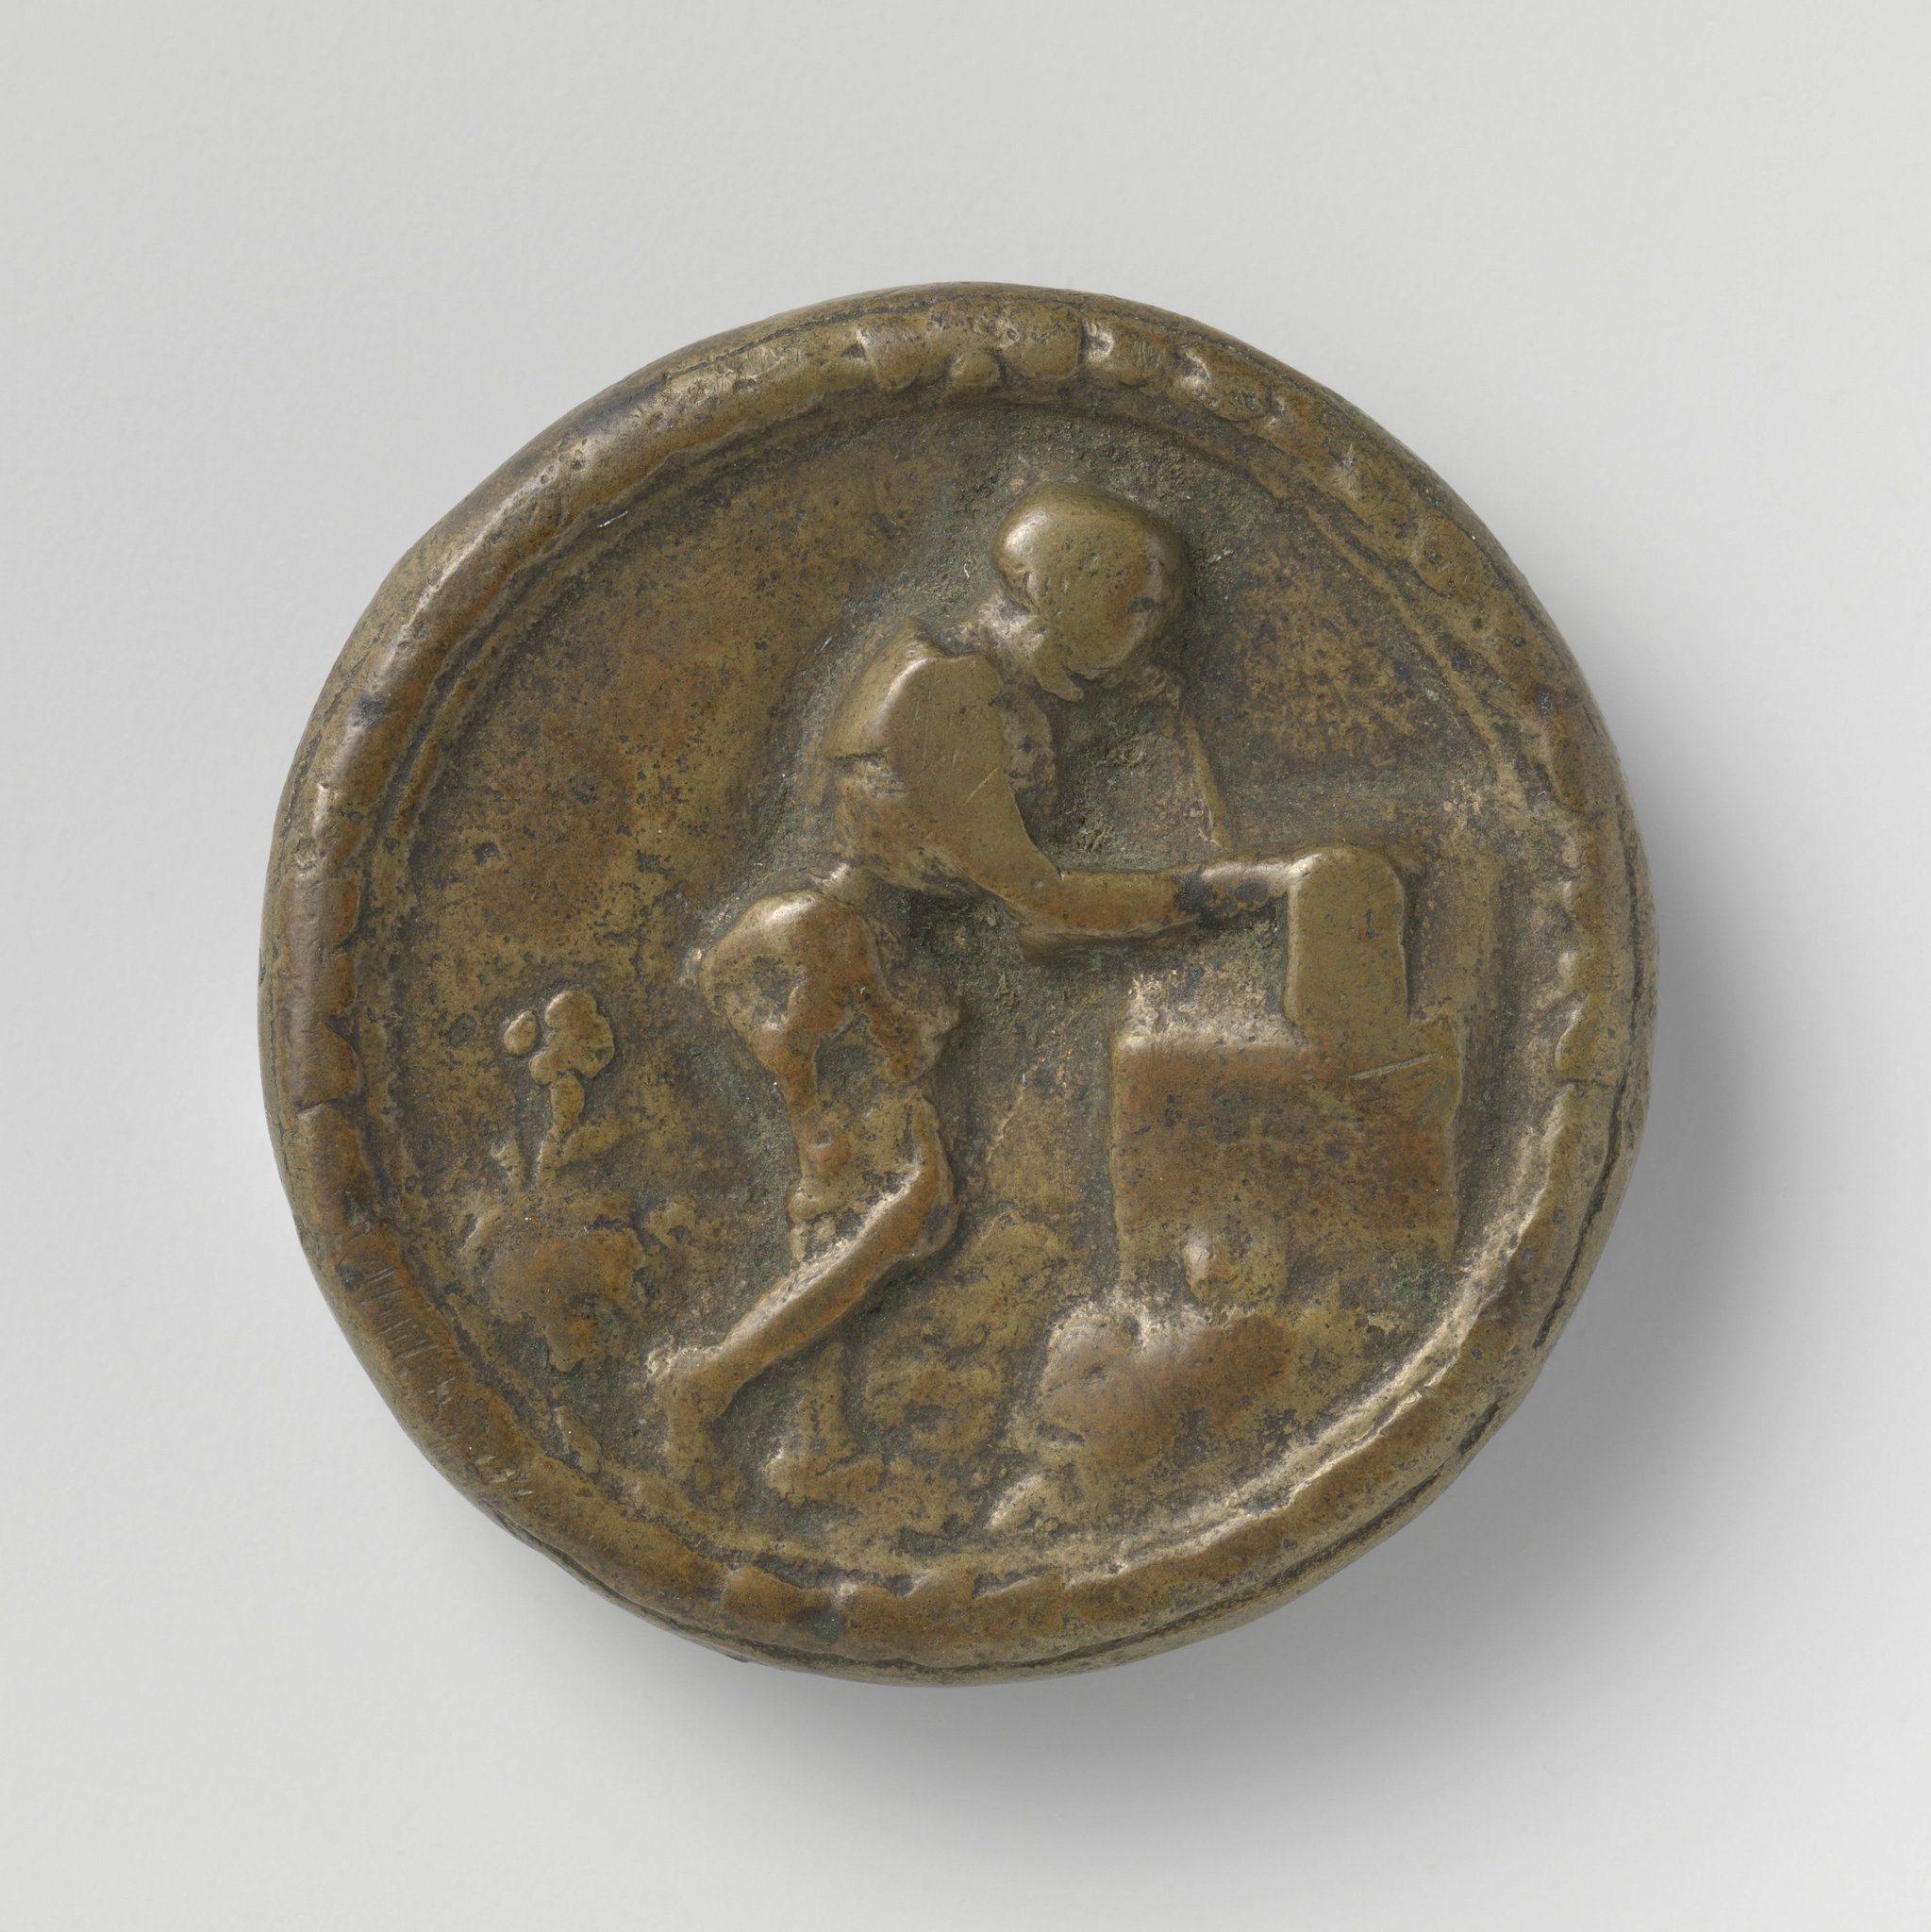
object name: medal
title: Chirurgijnsgilde te Amsterdam, gildepenning van Mr. Hendrick Smeeckes, chirurgijn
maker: Anonymous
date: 1688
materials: brass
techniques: casting, engraving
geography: amsterdam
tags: amsterdam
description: Messing penning. Voorzijde: Dood, afgebeeld als geraamte, met rechterarm op zandloper en met linkerelleboog leunend op altaar binnen bladerkrans. Keerzijde: opschrift